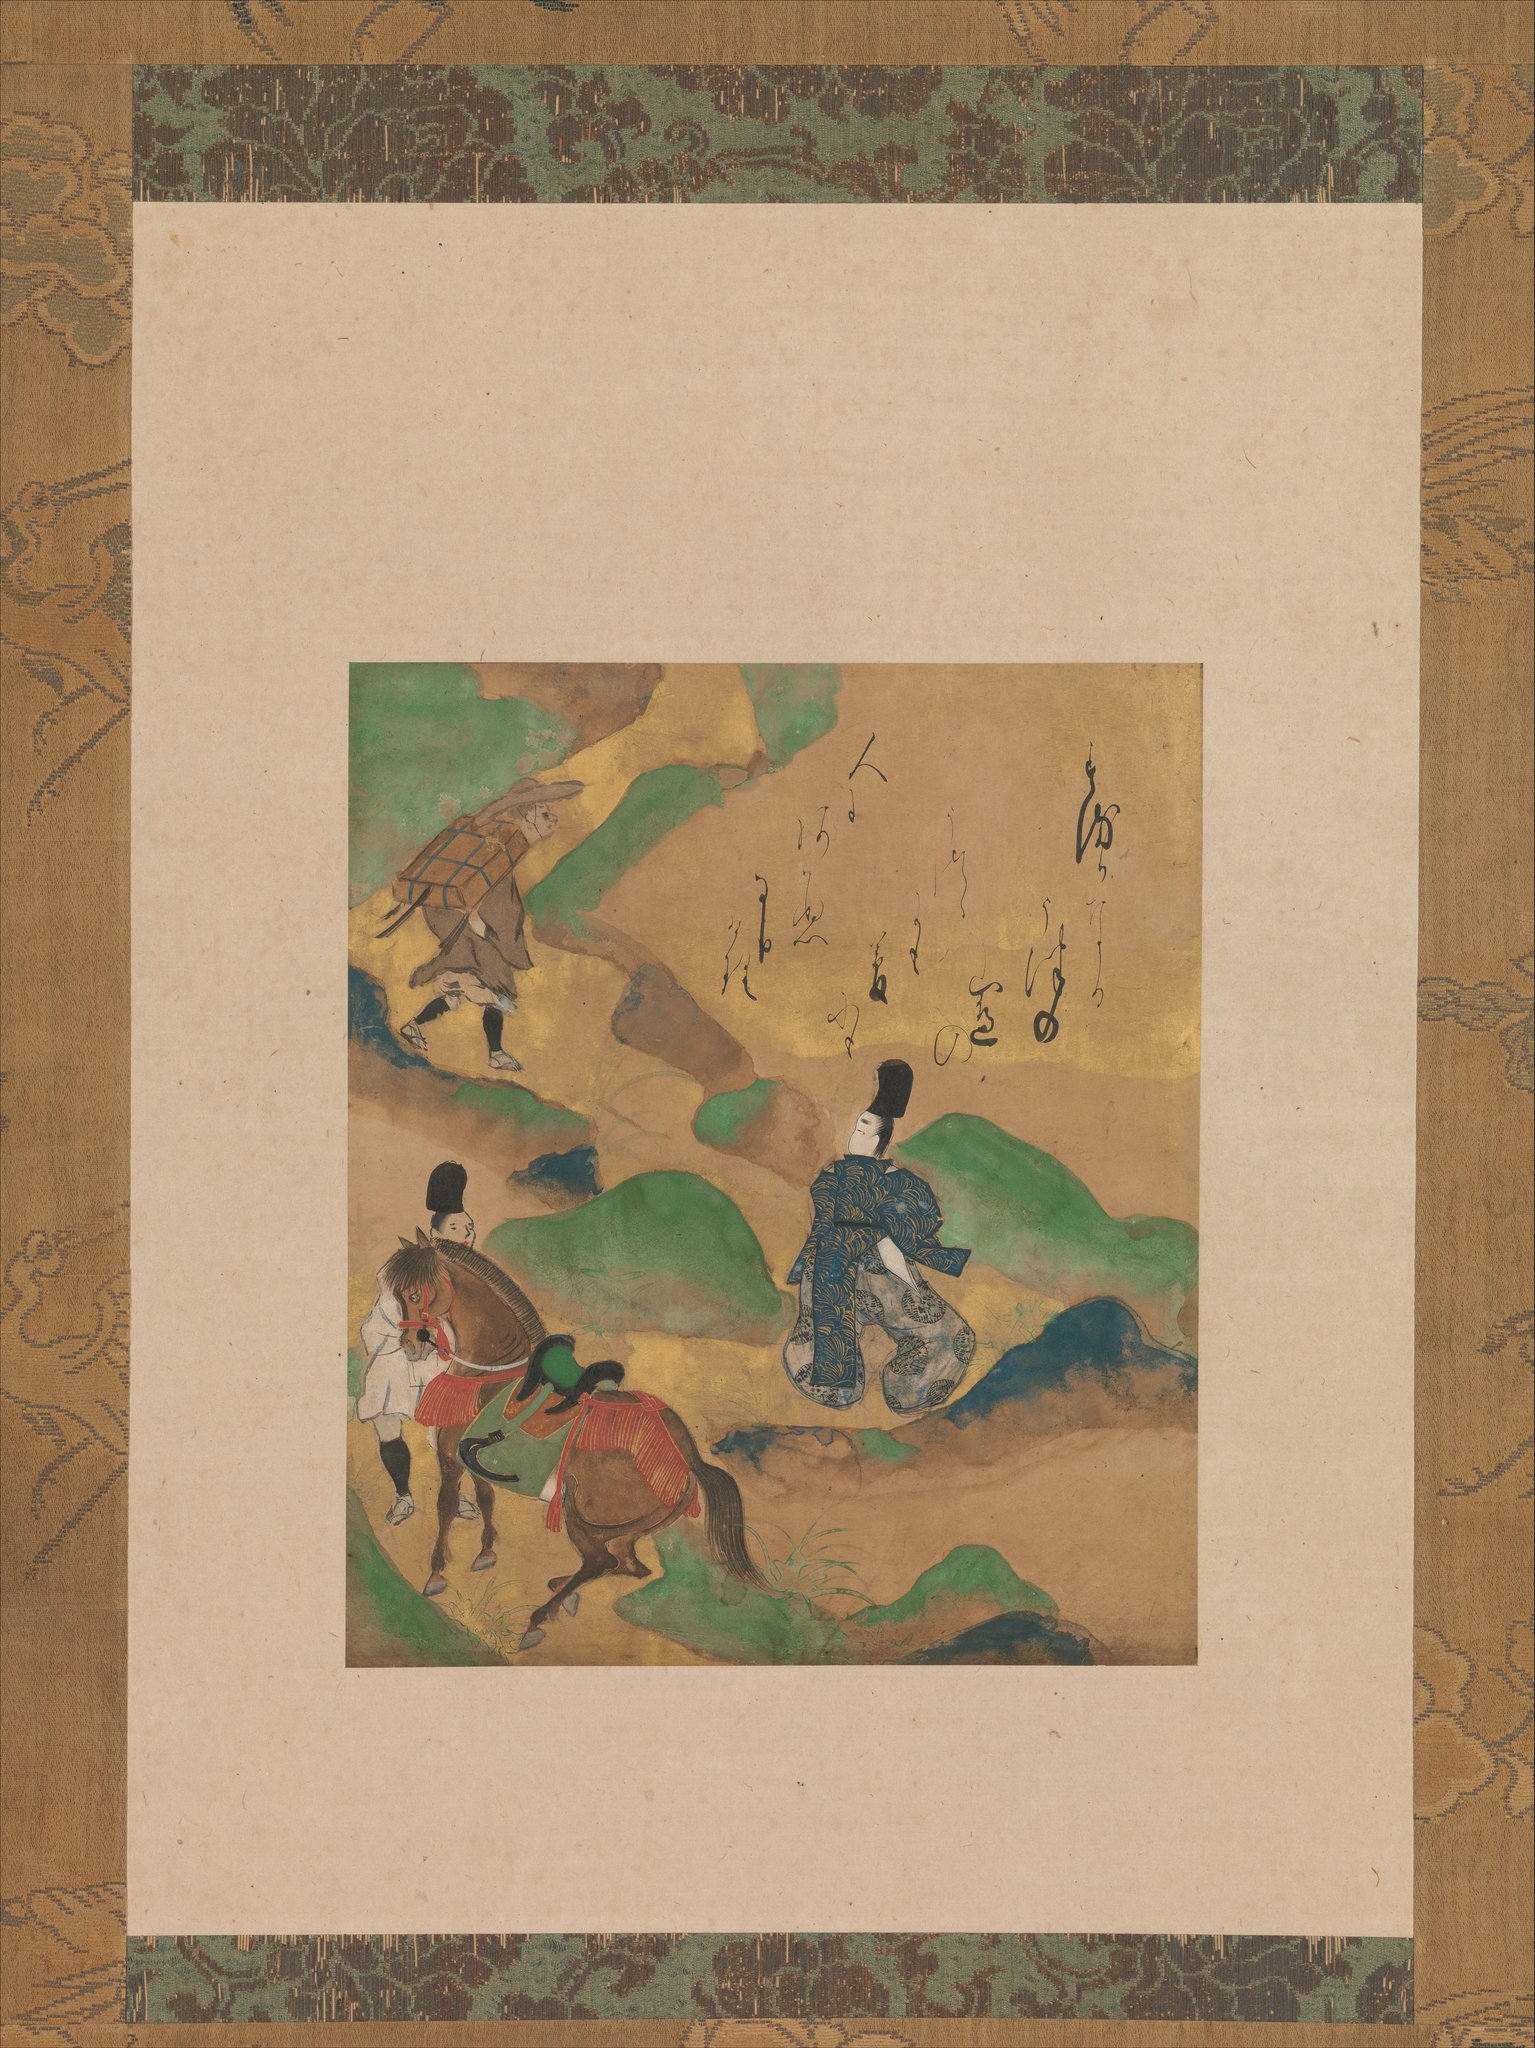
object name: hanging scroll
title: “Mount Utsu” (Utsu no yama), from The Tales of Ise (Ise monogatari)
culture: japanese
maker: tawaraya sōtatsu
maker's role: artist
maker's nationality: japanese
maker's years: 1570-1640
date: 1634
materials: gold, ink, paper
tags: men,horses